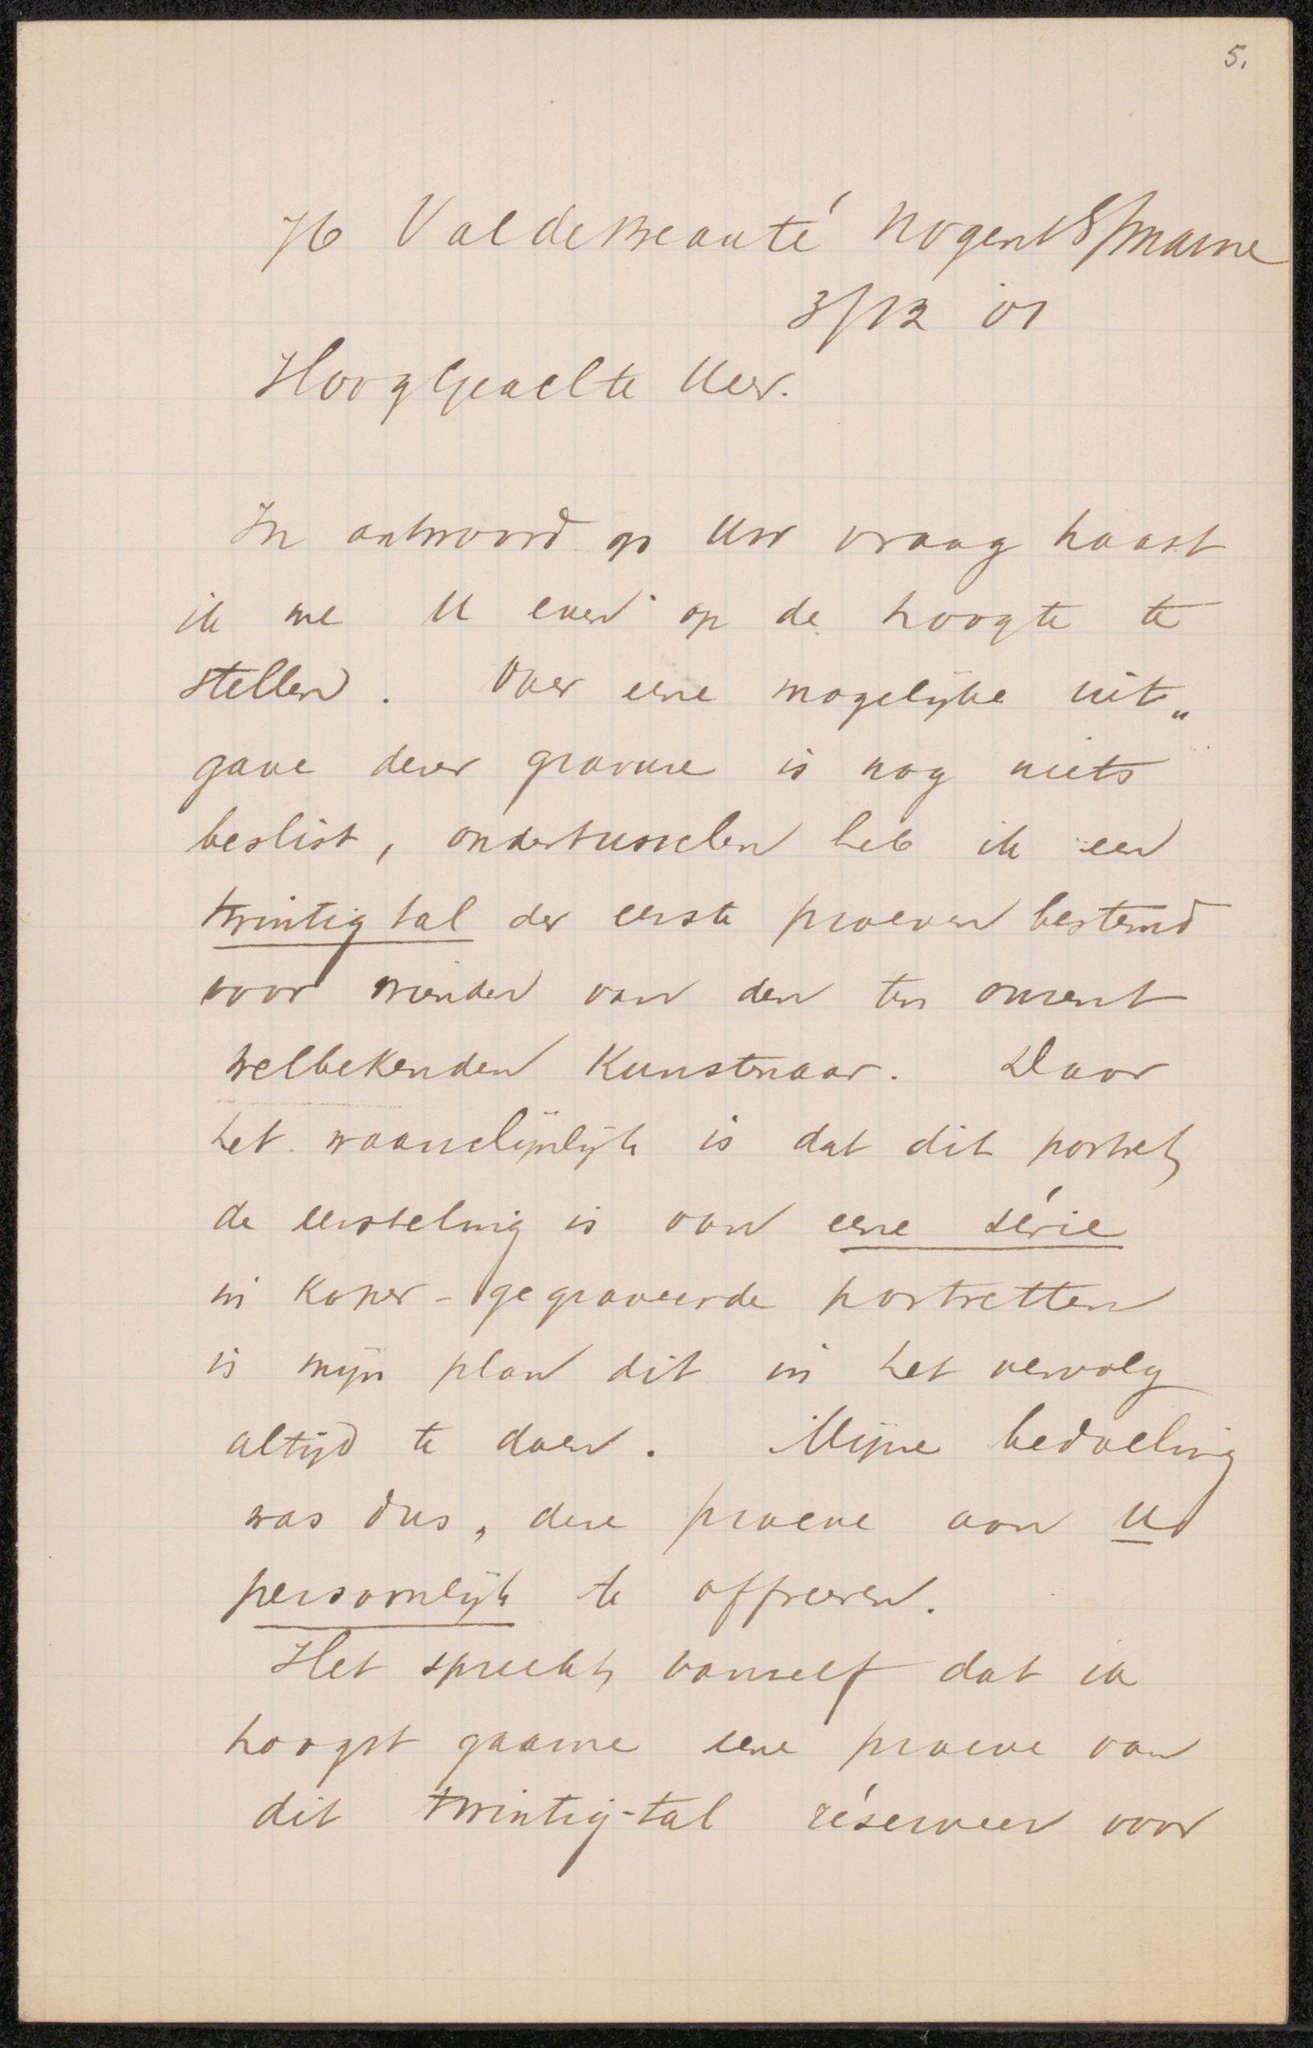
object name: letter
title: Brief aan Pieter Haverkorn van Rijsewijk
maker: pieter dupont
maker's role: draughtsman, print maker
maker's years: 1870-1911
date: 1901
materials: ink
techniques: pen, writing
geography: nogent-sur-marne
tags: pieter haverkorn van rijsewijk, the graphic arts, anonymous historical person portrayed, exhibition ~ art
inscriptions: collector's mark: ‘RPK’